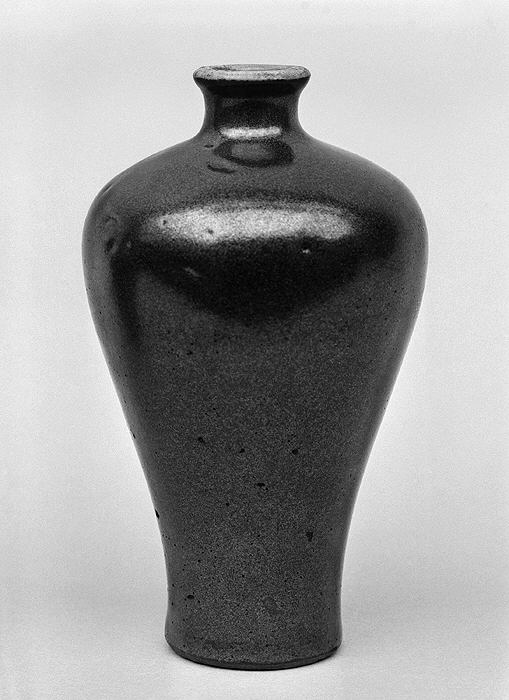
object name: vase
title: Minature meiping vase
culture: chinese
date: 1701-1800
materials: glaze, iron, porcelain